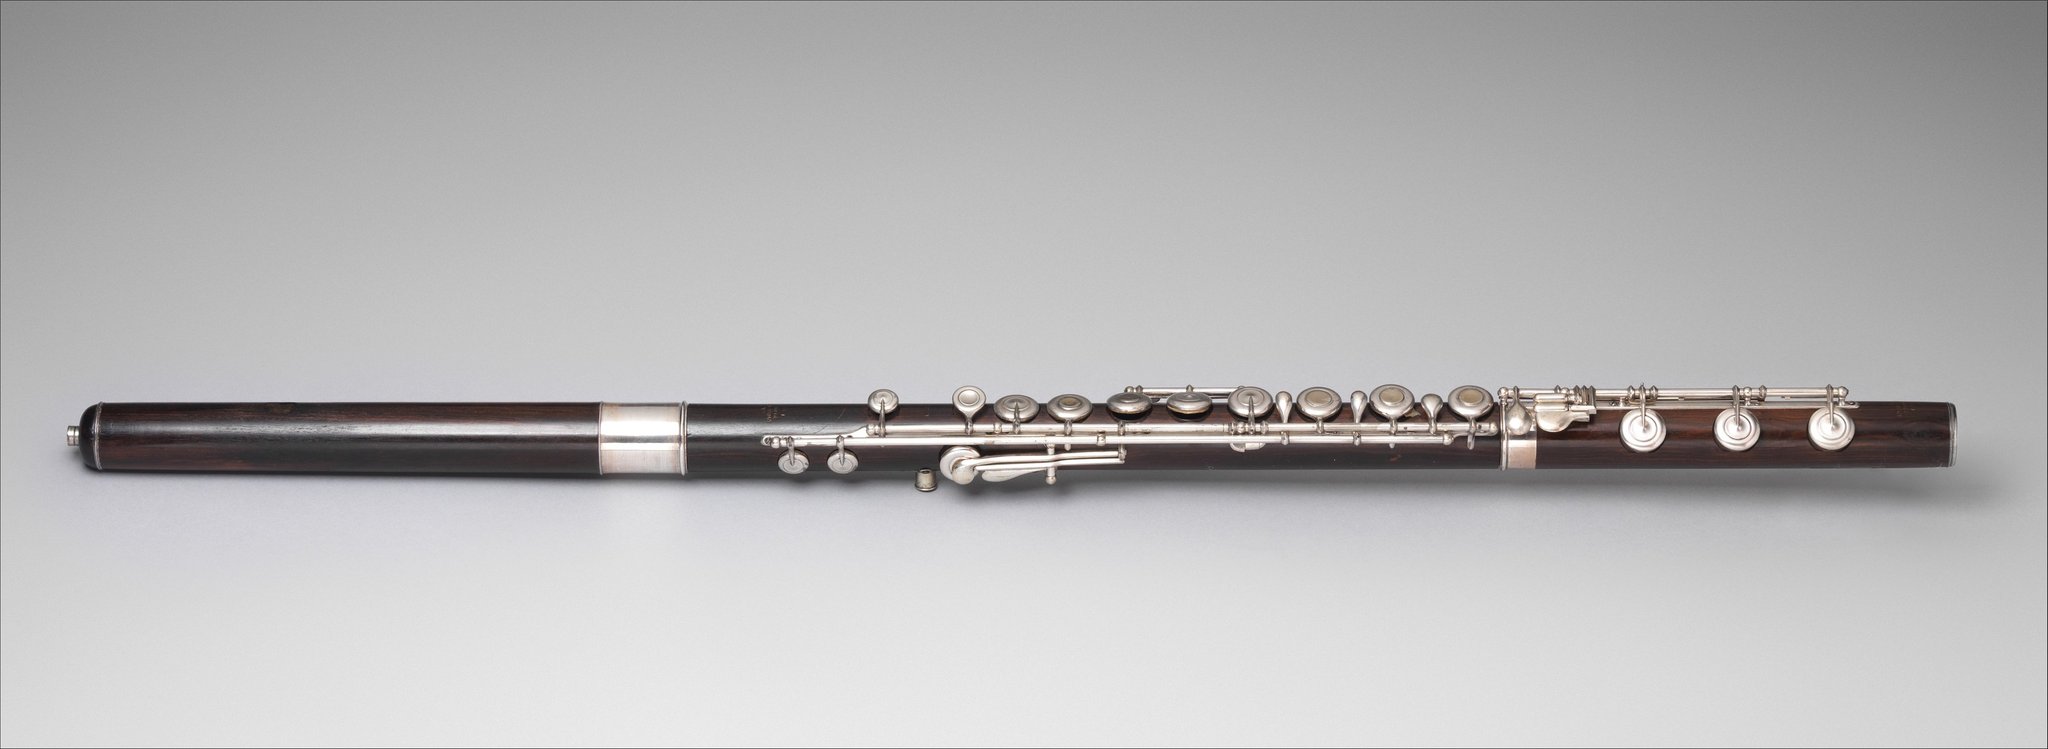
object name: transverse flute in c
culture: french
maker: louis lot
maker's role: maker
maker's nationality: french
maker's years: 1807-1896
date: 1856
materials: metal, wood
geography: france